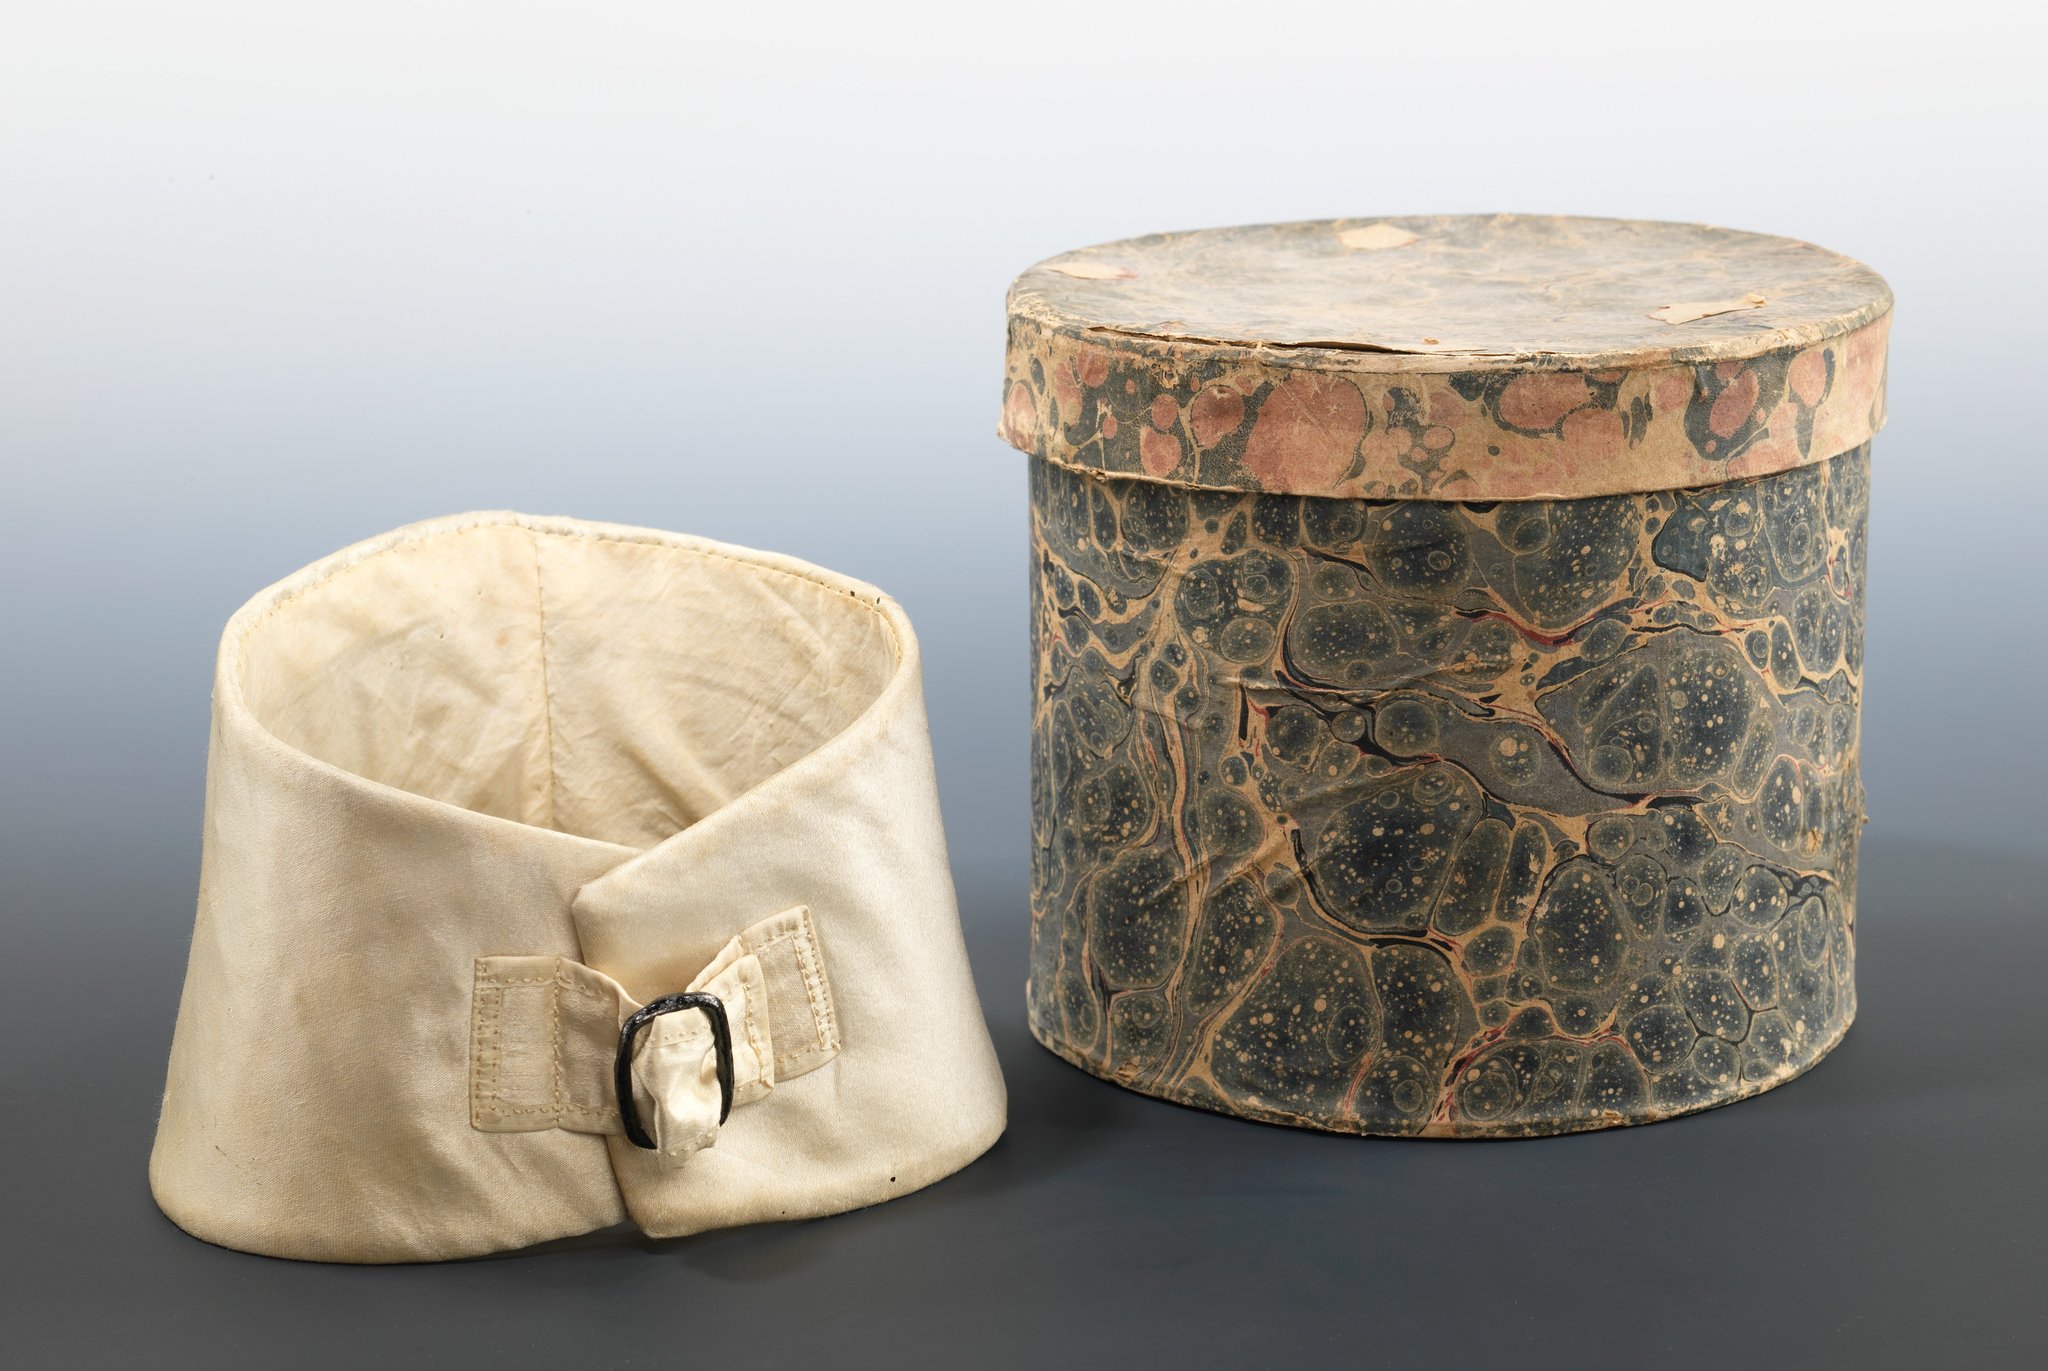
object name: stock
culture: american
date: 1830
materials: metal, silk